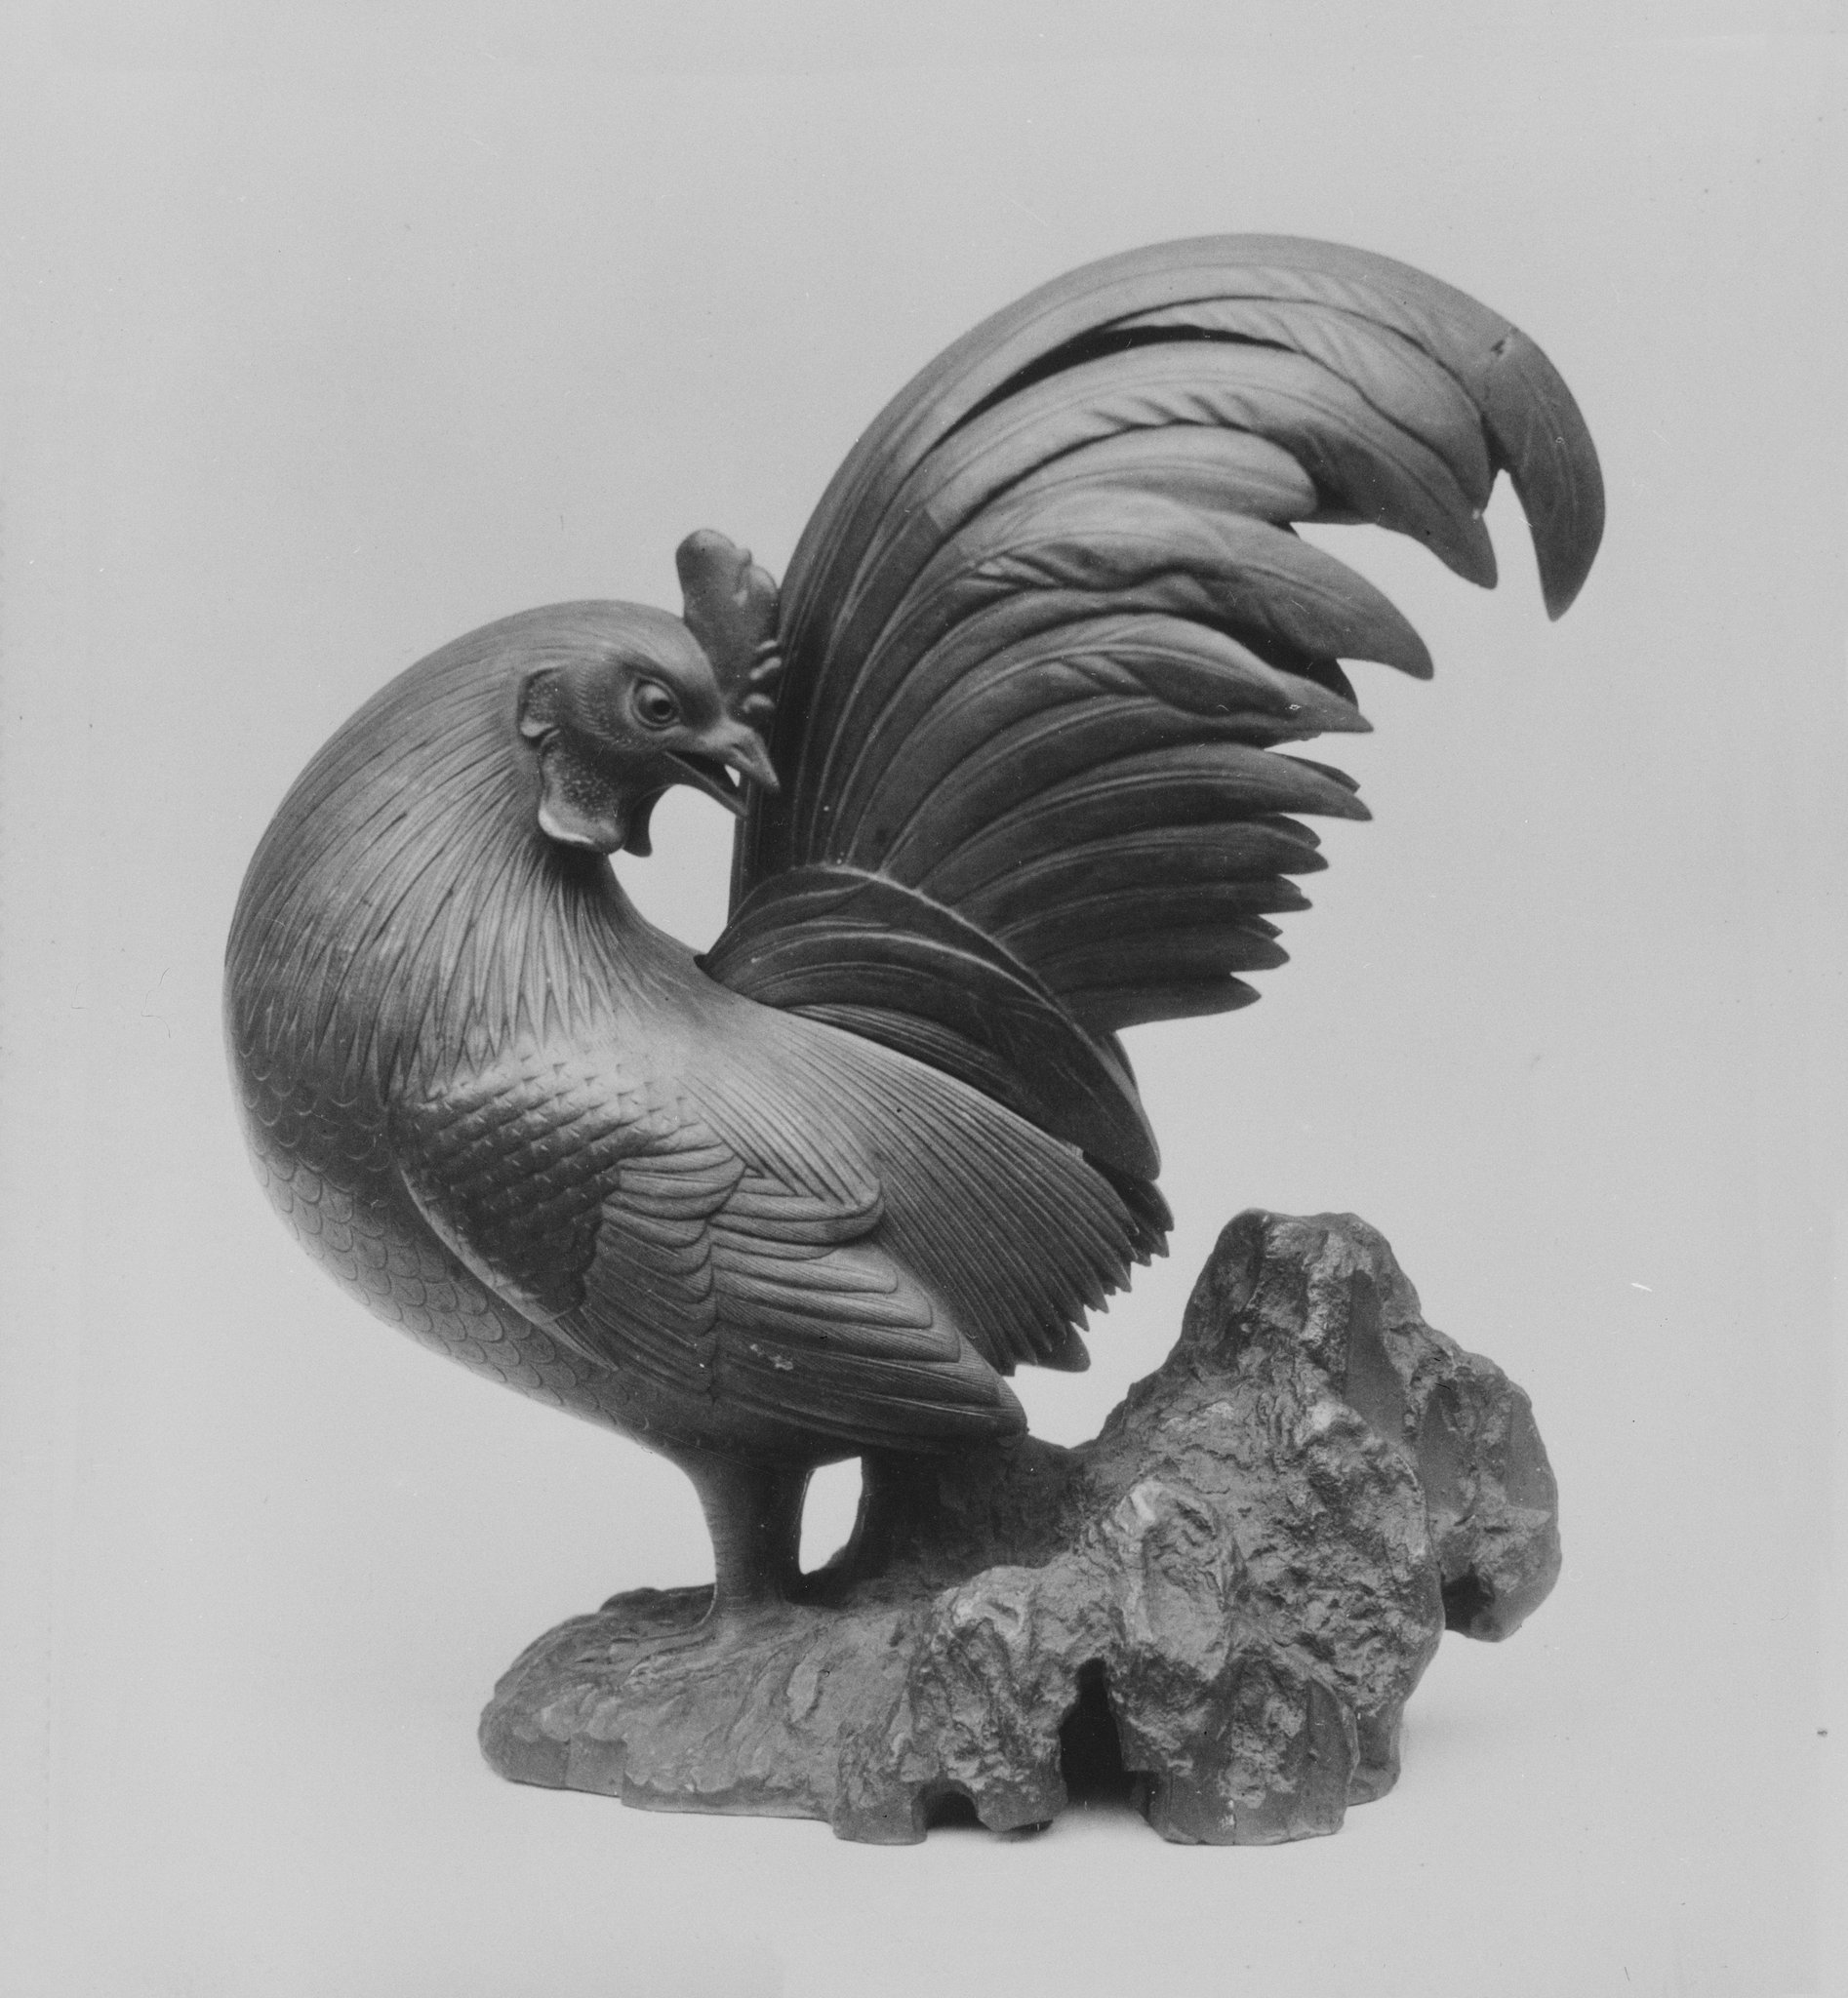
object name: censer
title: Censer in Form of a Cock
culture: japanese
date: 1700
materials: glaze, stoneware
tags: roosters,censers